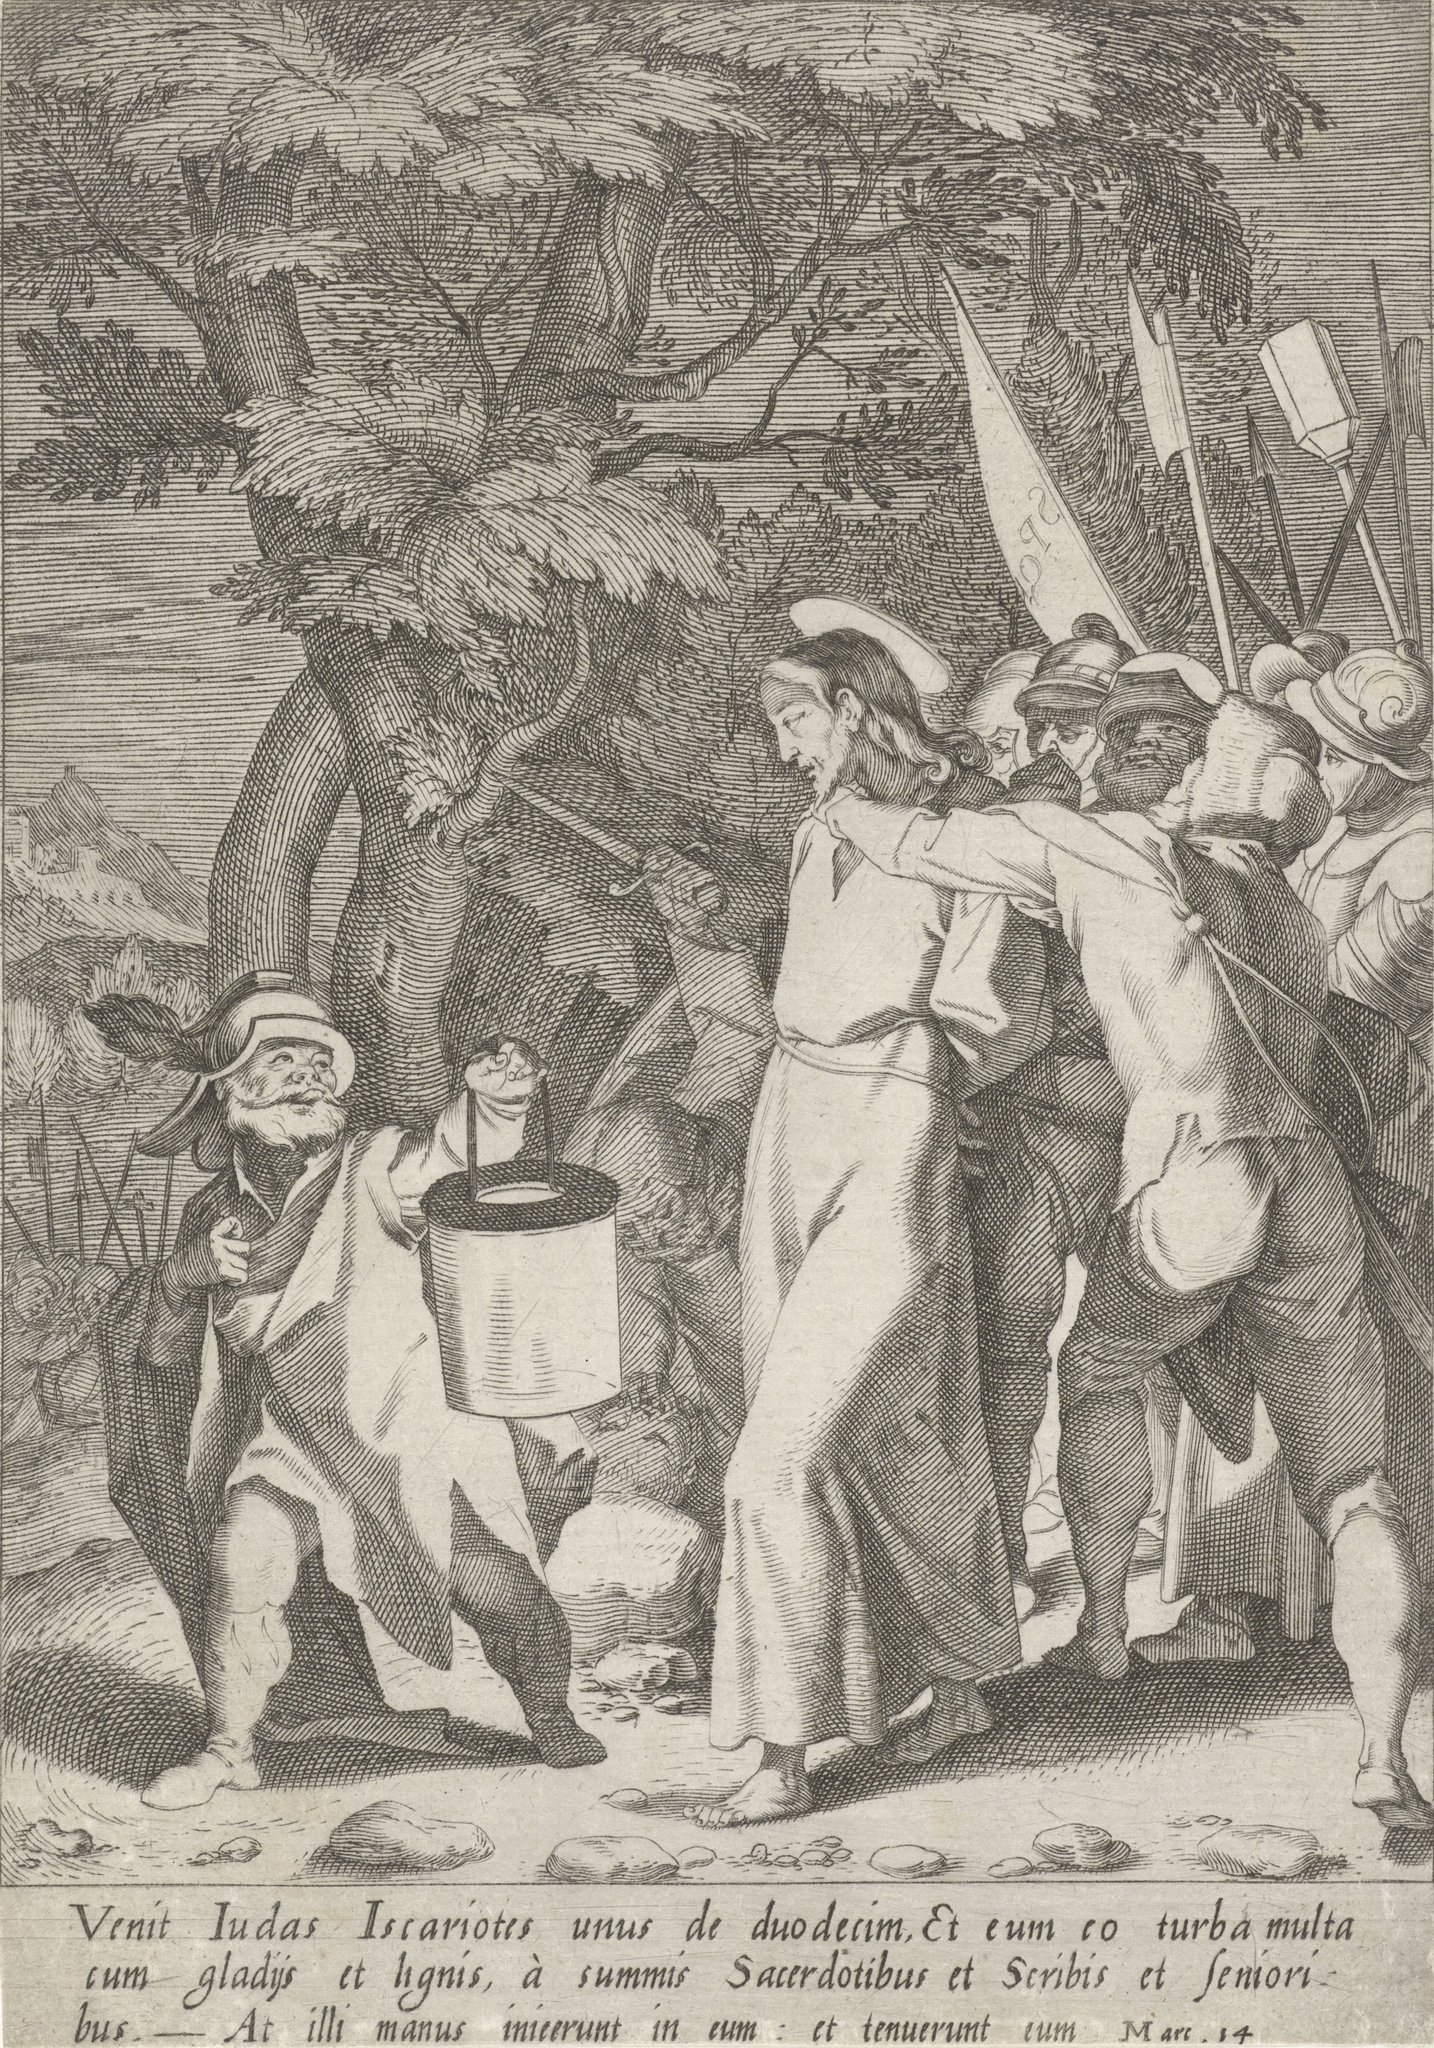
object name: print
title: Gevangenneming van Christus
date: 1590-1632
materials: paper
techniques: engraving, etching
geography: italy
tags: peter draws his sword and cuts off malchus' ear, the arrest of christ ~ garden of gethsemane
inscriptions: collector's mark: Lugt 2228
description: Christus wordt in de hof van Getsemane gevangen genomen door soldaten die zich met hellebaarden en lantaarns rond hem verzamelen. Hij wordt geketend om zijn hals. Op de achtergrond heeft Simon Petrus met een zwaard het rechteroor van de slaaf Malchus afgeslagen. In de marge een drieregelig onderschrift in het Latijn. Prent uit een serie van vijftien met de passie van Christus.